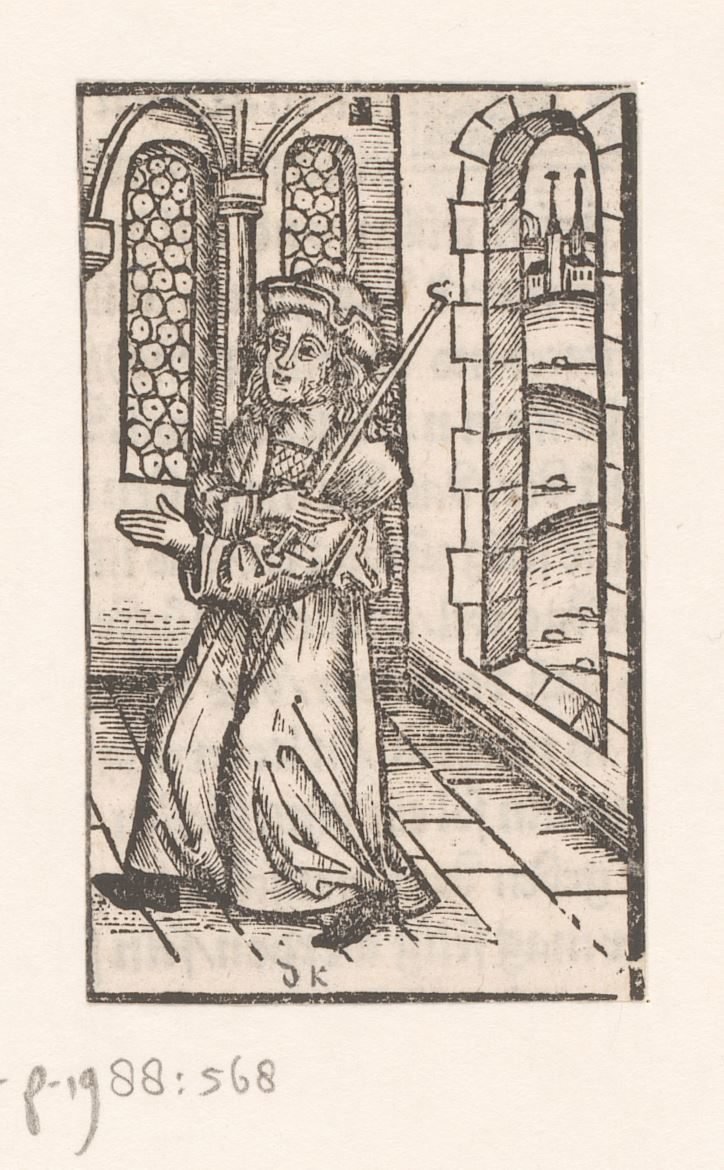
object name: book illustration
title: Man met een scepter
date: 1500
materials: paper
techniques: woodcut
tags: the virgin martyr catherine of alexandria; possible attributes: book, crown, emperor maxentius, palm-branch, ring, sword, wheel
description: Illustraties uit: Frater Petrus. Legenda S. Katharinae. Straatsburg: Johann Grüninger, 1500.